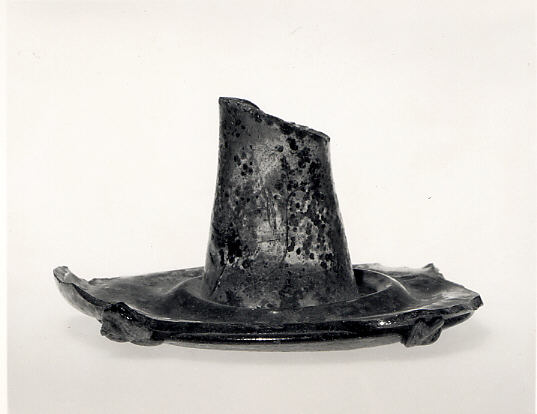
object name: fragment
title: Fragment of Inkwell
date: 901-1000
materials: glass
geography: iran